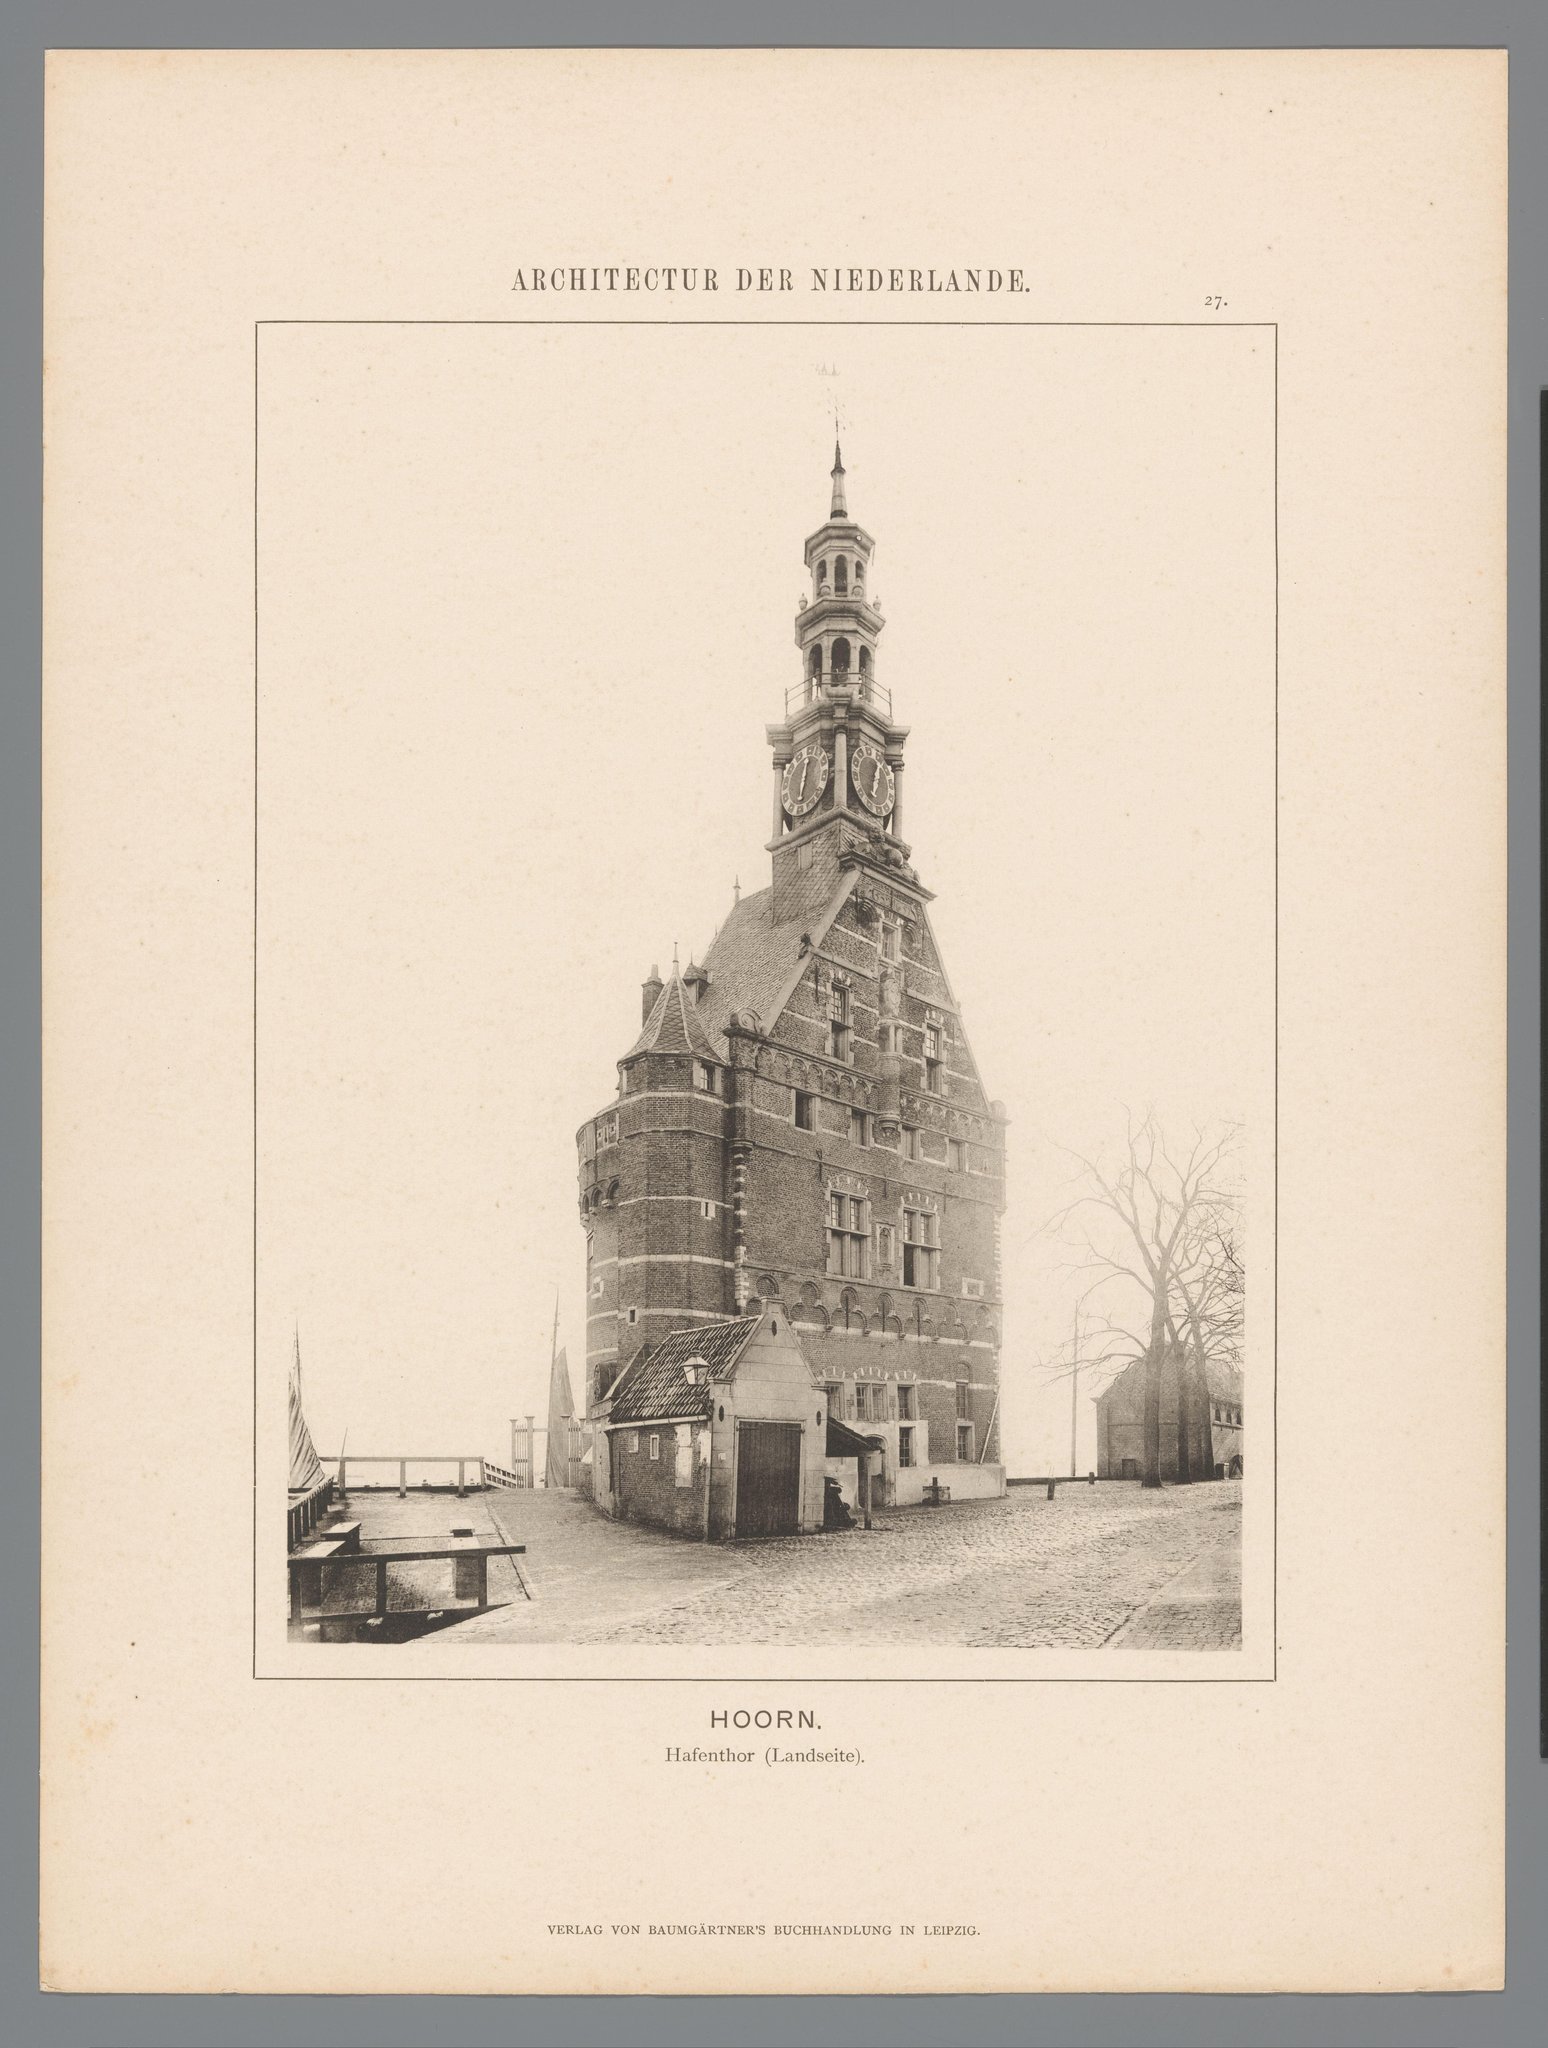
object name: photomechanical print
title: Architectur der Niederlande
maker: Anonymous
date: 1894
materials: paper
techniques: photograph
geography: leipzig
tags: permanent fortifications, hoorn (north holland)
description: Afdruk uit: Krook, L. Architectur der Niederlande. Leipzig: Baumgärtner's Buchhandlung, 1894.